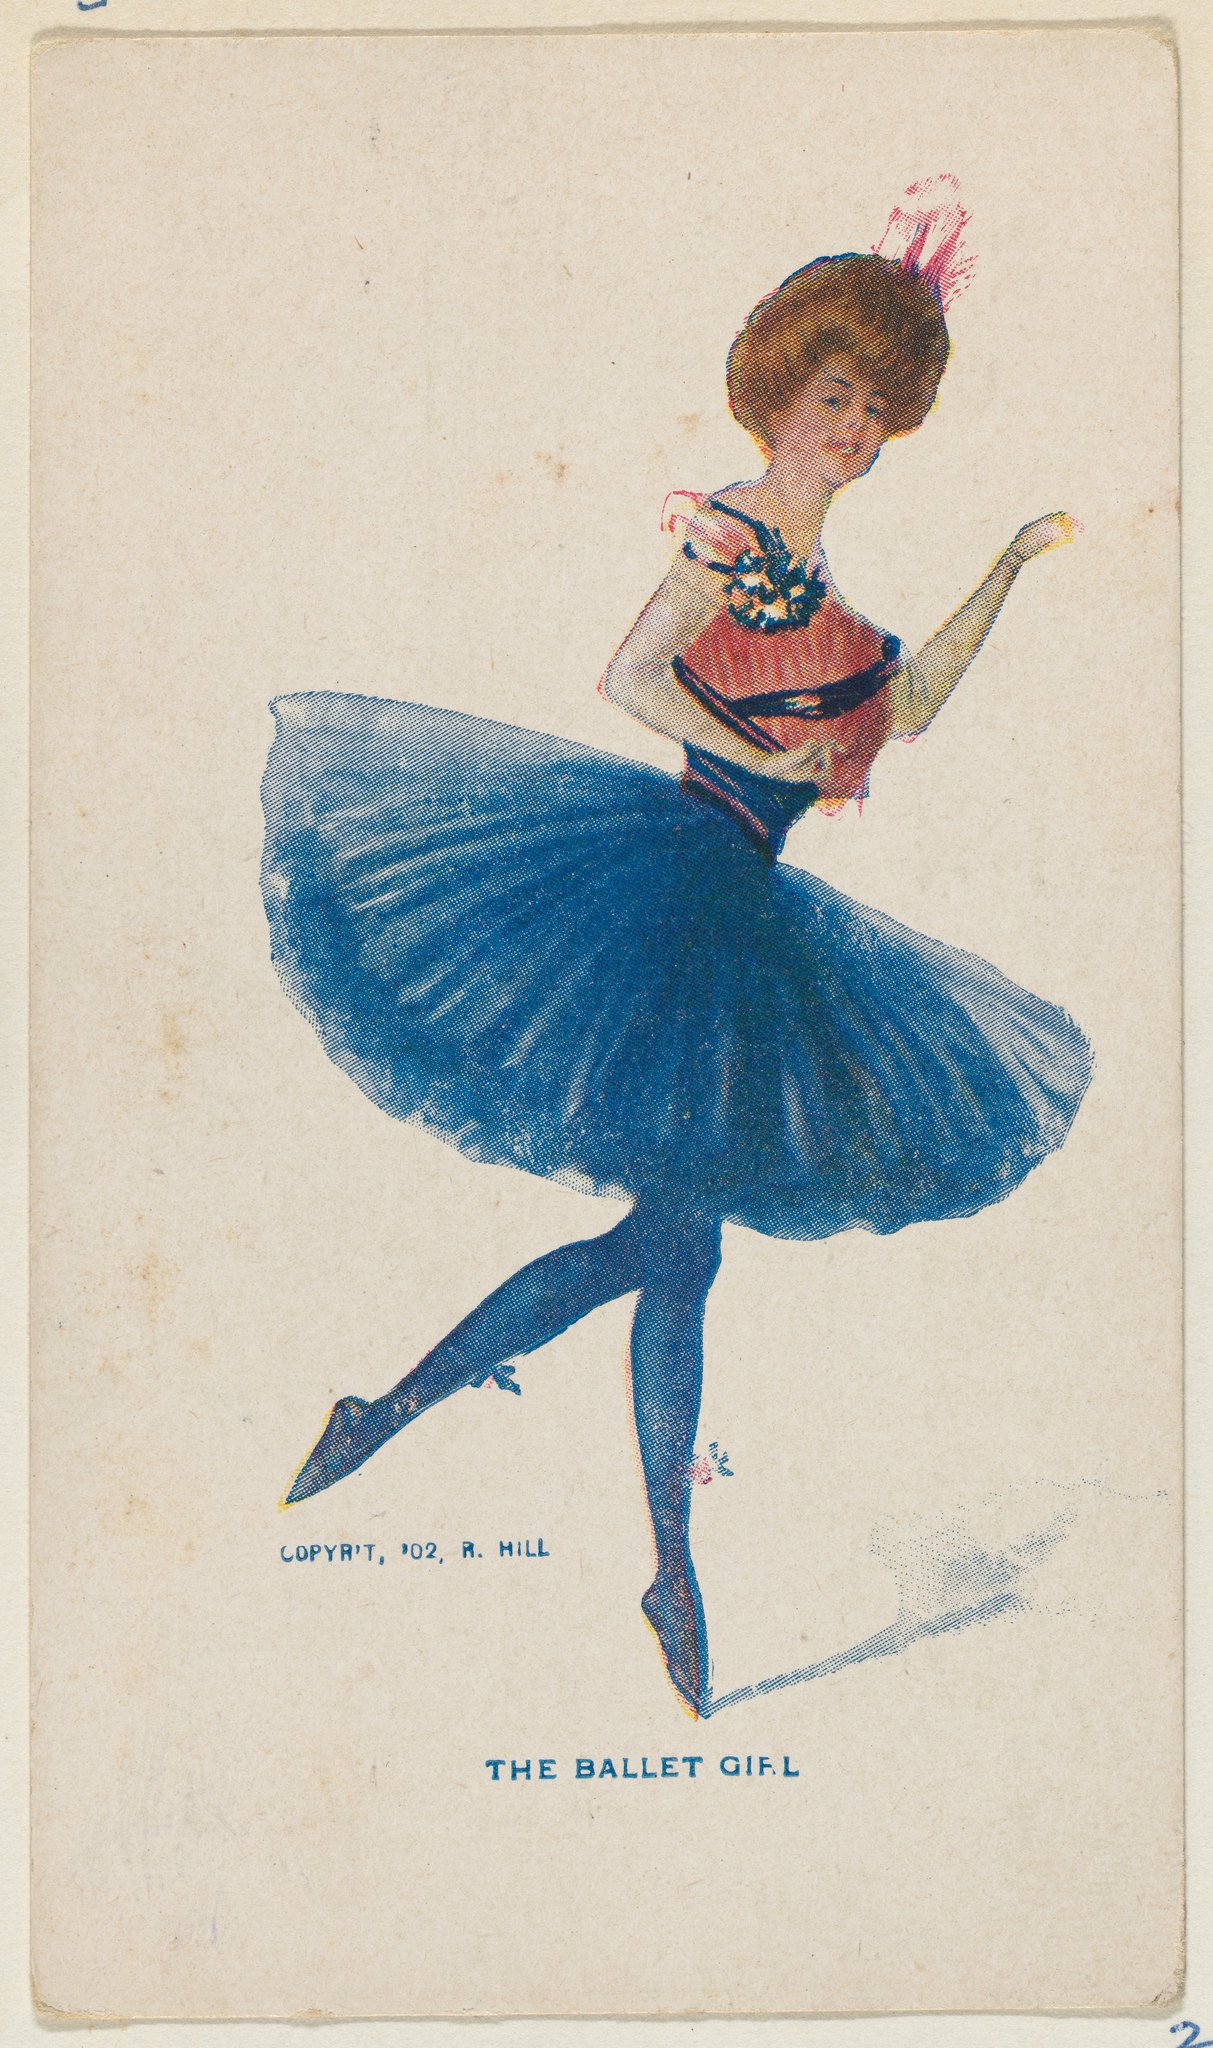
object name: print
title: The Ballet Girl, from the "Girls and Men in Costume" series (T65), issued with Golden Eagle Cigars by I. Lewis & Co.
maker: i. lewis & co., newark, new jersey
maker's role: publisher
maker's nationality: american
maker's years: 1850-1950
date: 1903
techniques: color lithograph